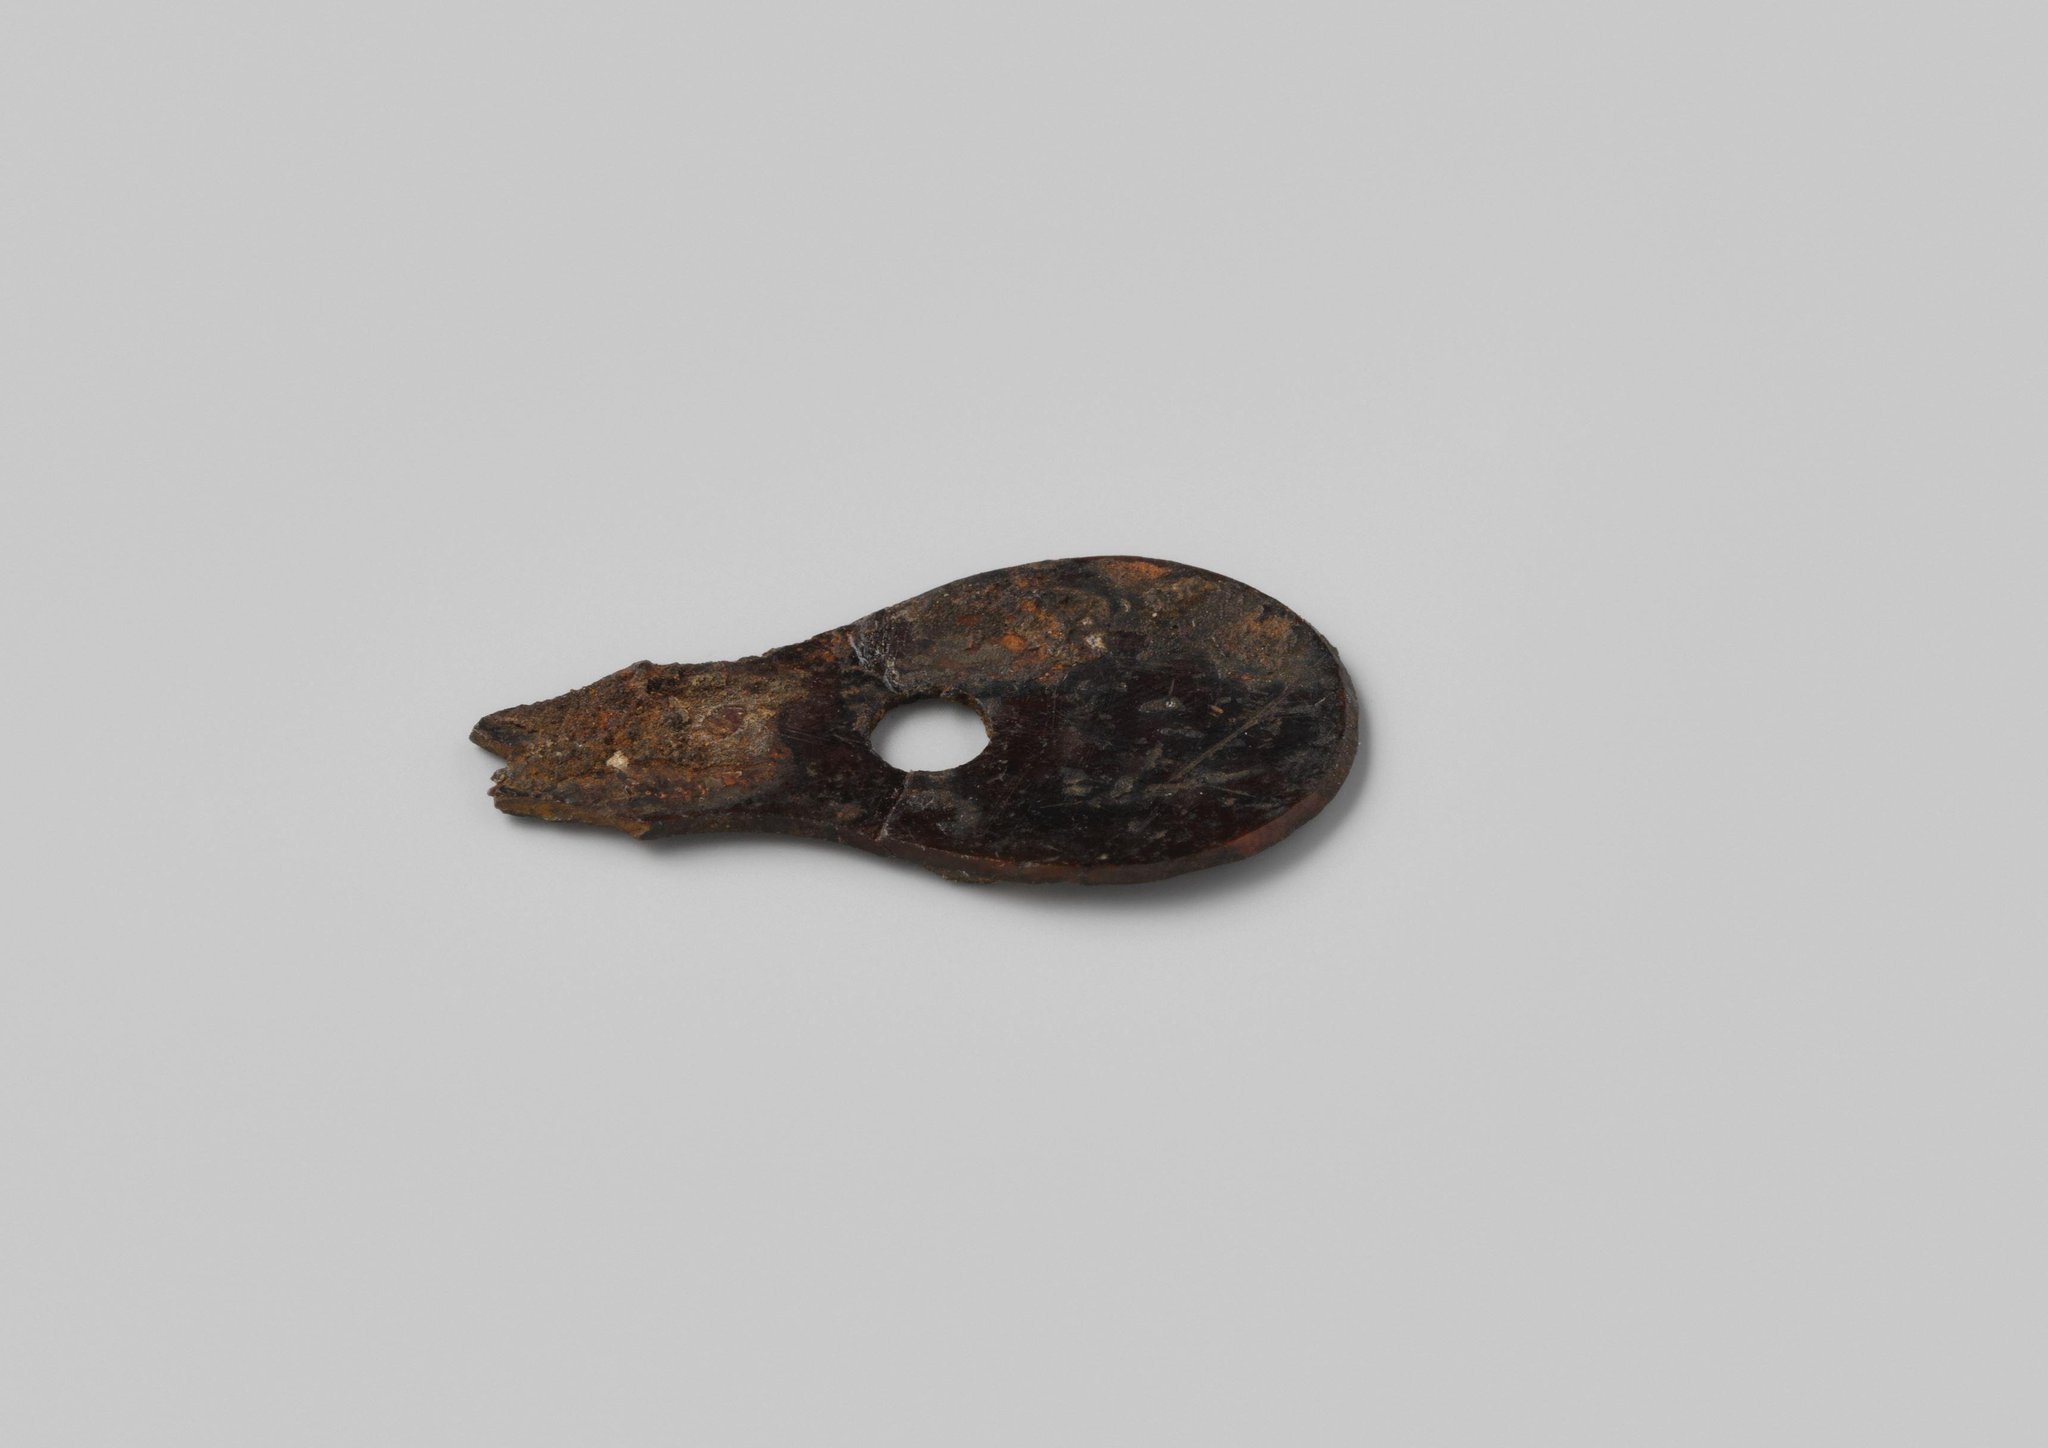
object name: bekroning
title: Bekroning of uiteinde uit het wrak van de Oost-Indiëvaarder Hollandia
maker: Anonymous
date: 1700-1743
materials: bone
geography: netherlands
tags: verenigde oostindische compagnie, hollandia (schip), annet